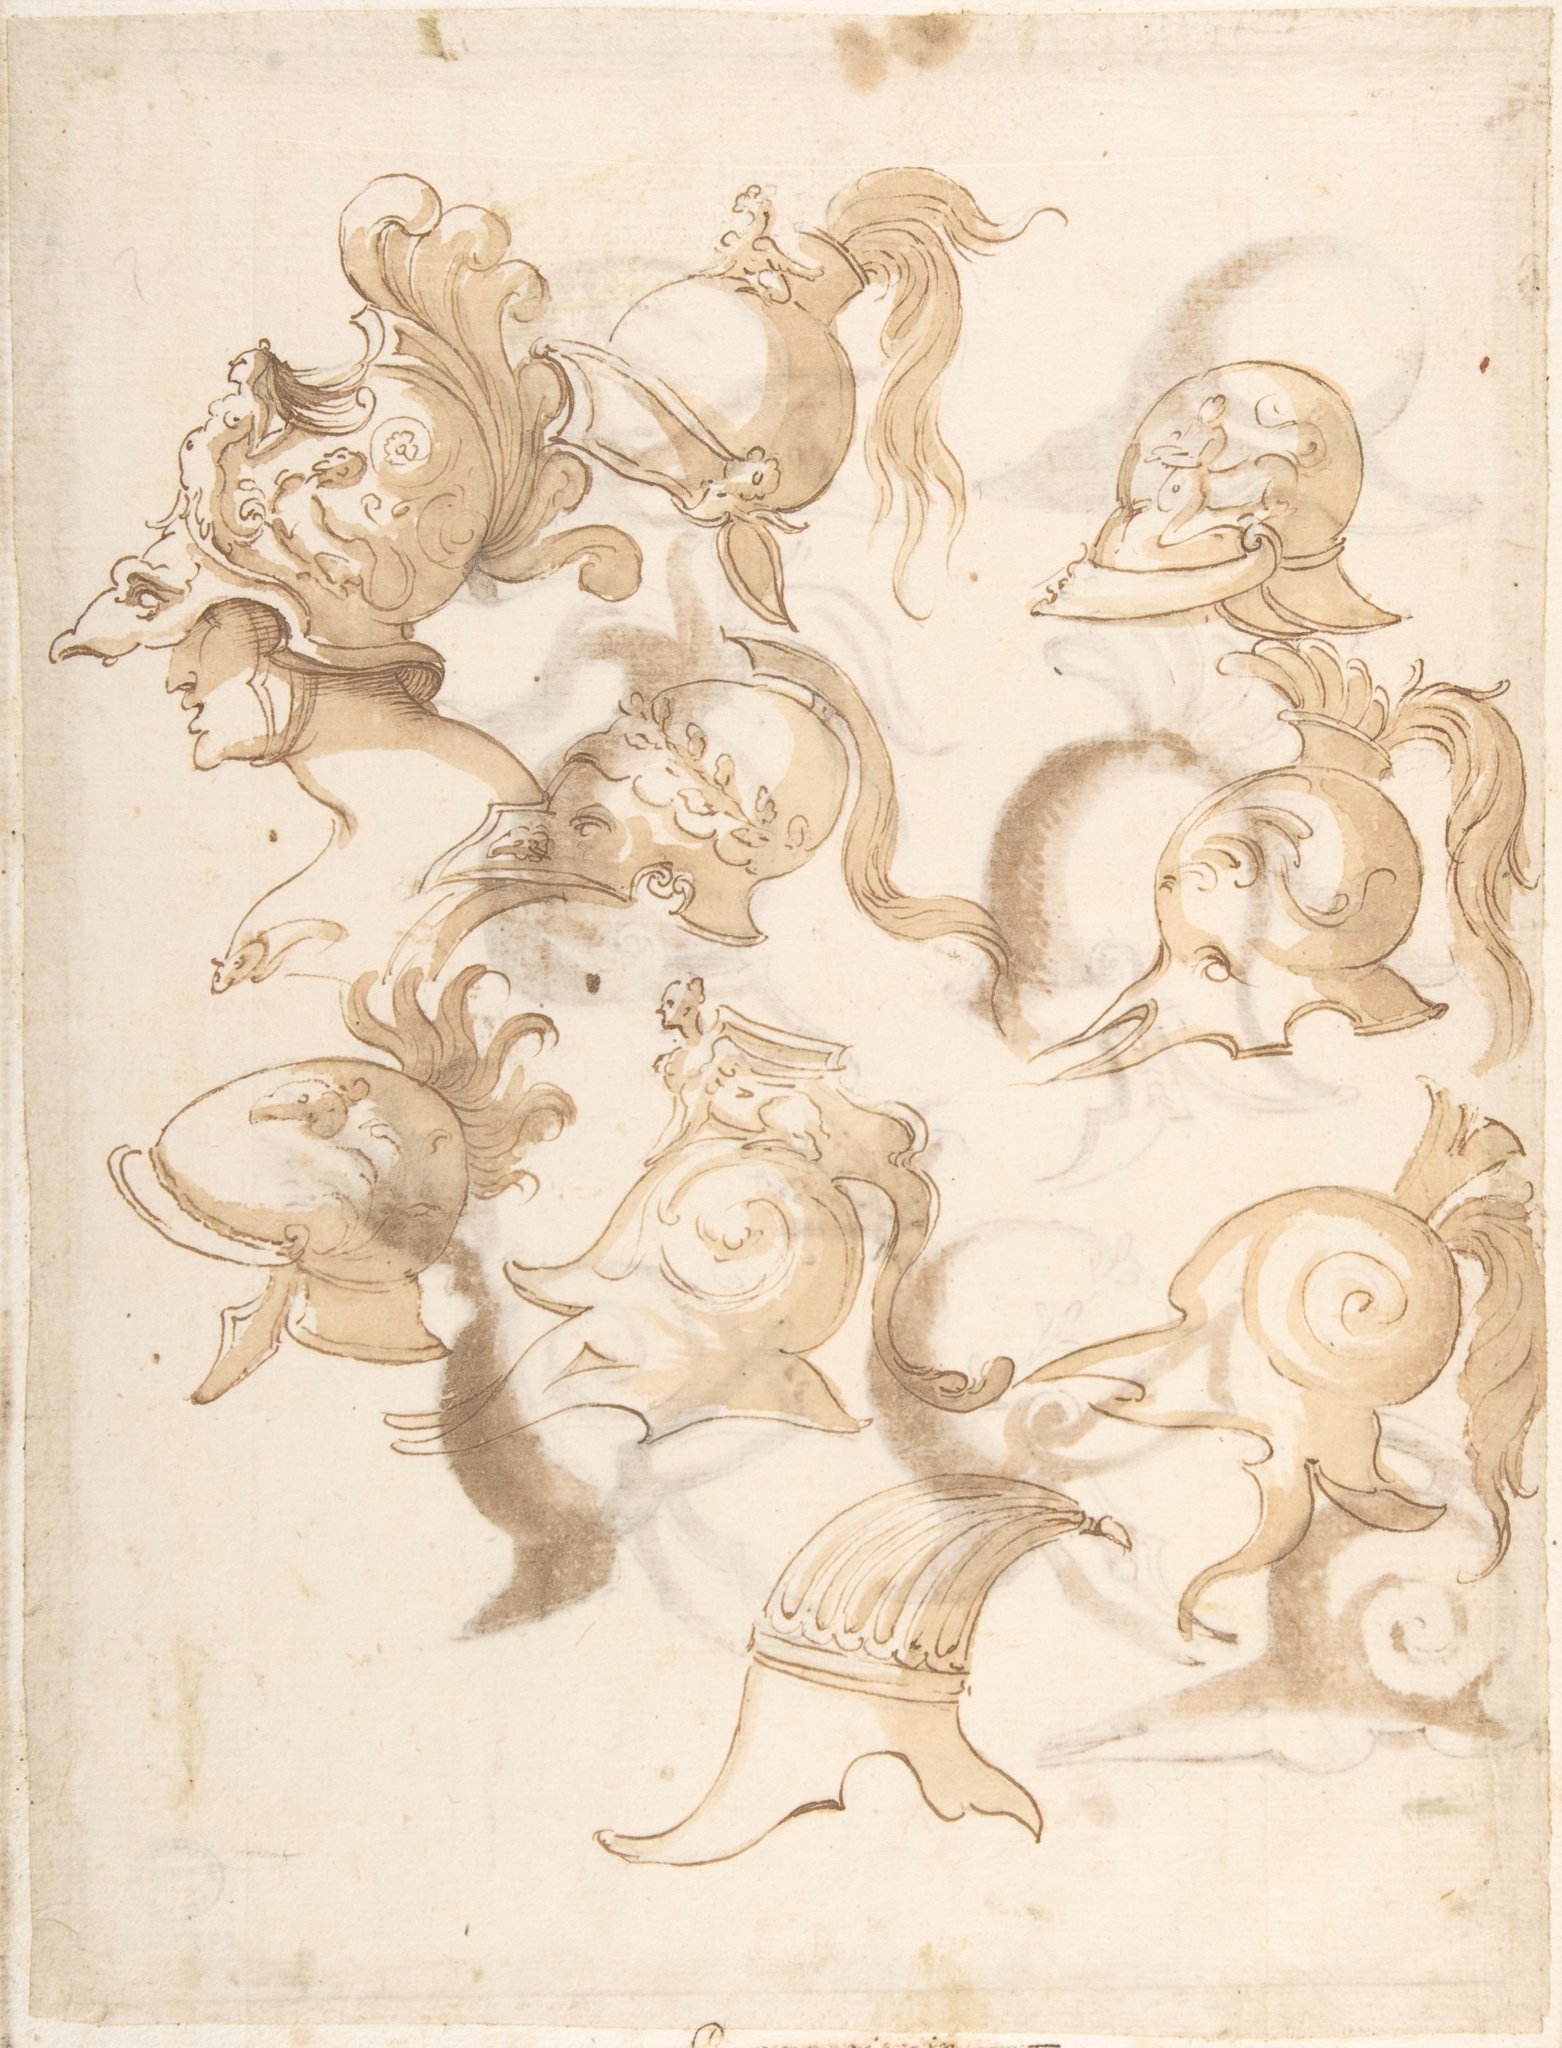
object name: drawing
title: Designs for Nine Helmets (recto); Designs for Seven Helmets (verso)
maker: anonymous, italian, 16th century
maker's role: artist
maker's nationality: italian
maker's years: 1550-1600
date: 1501-1600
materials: ink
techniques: brush, pen, wash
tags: helmets,men